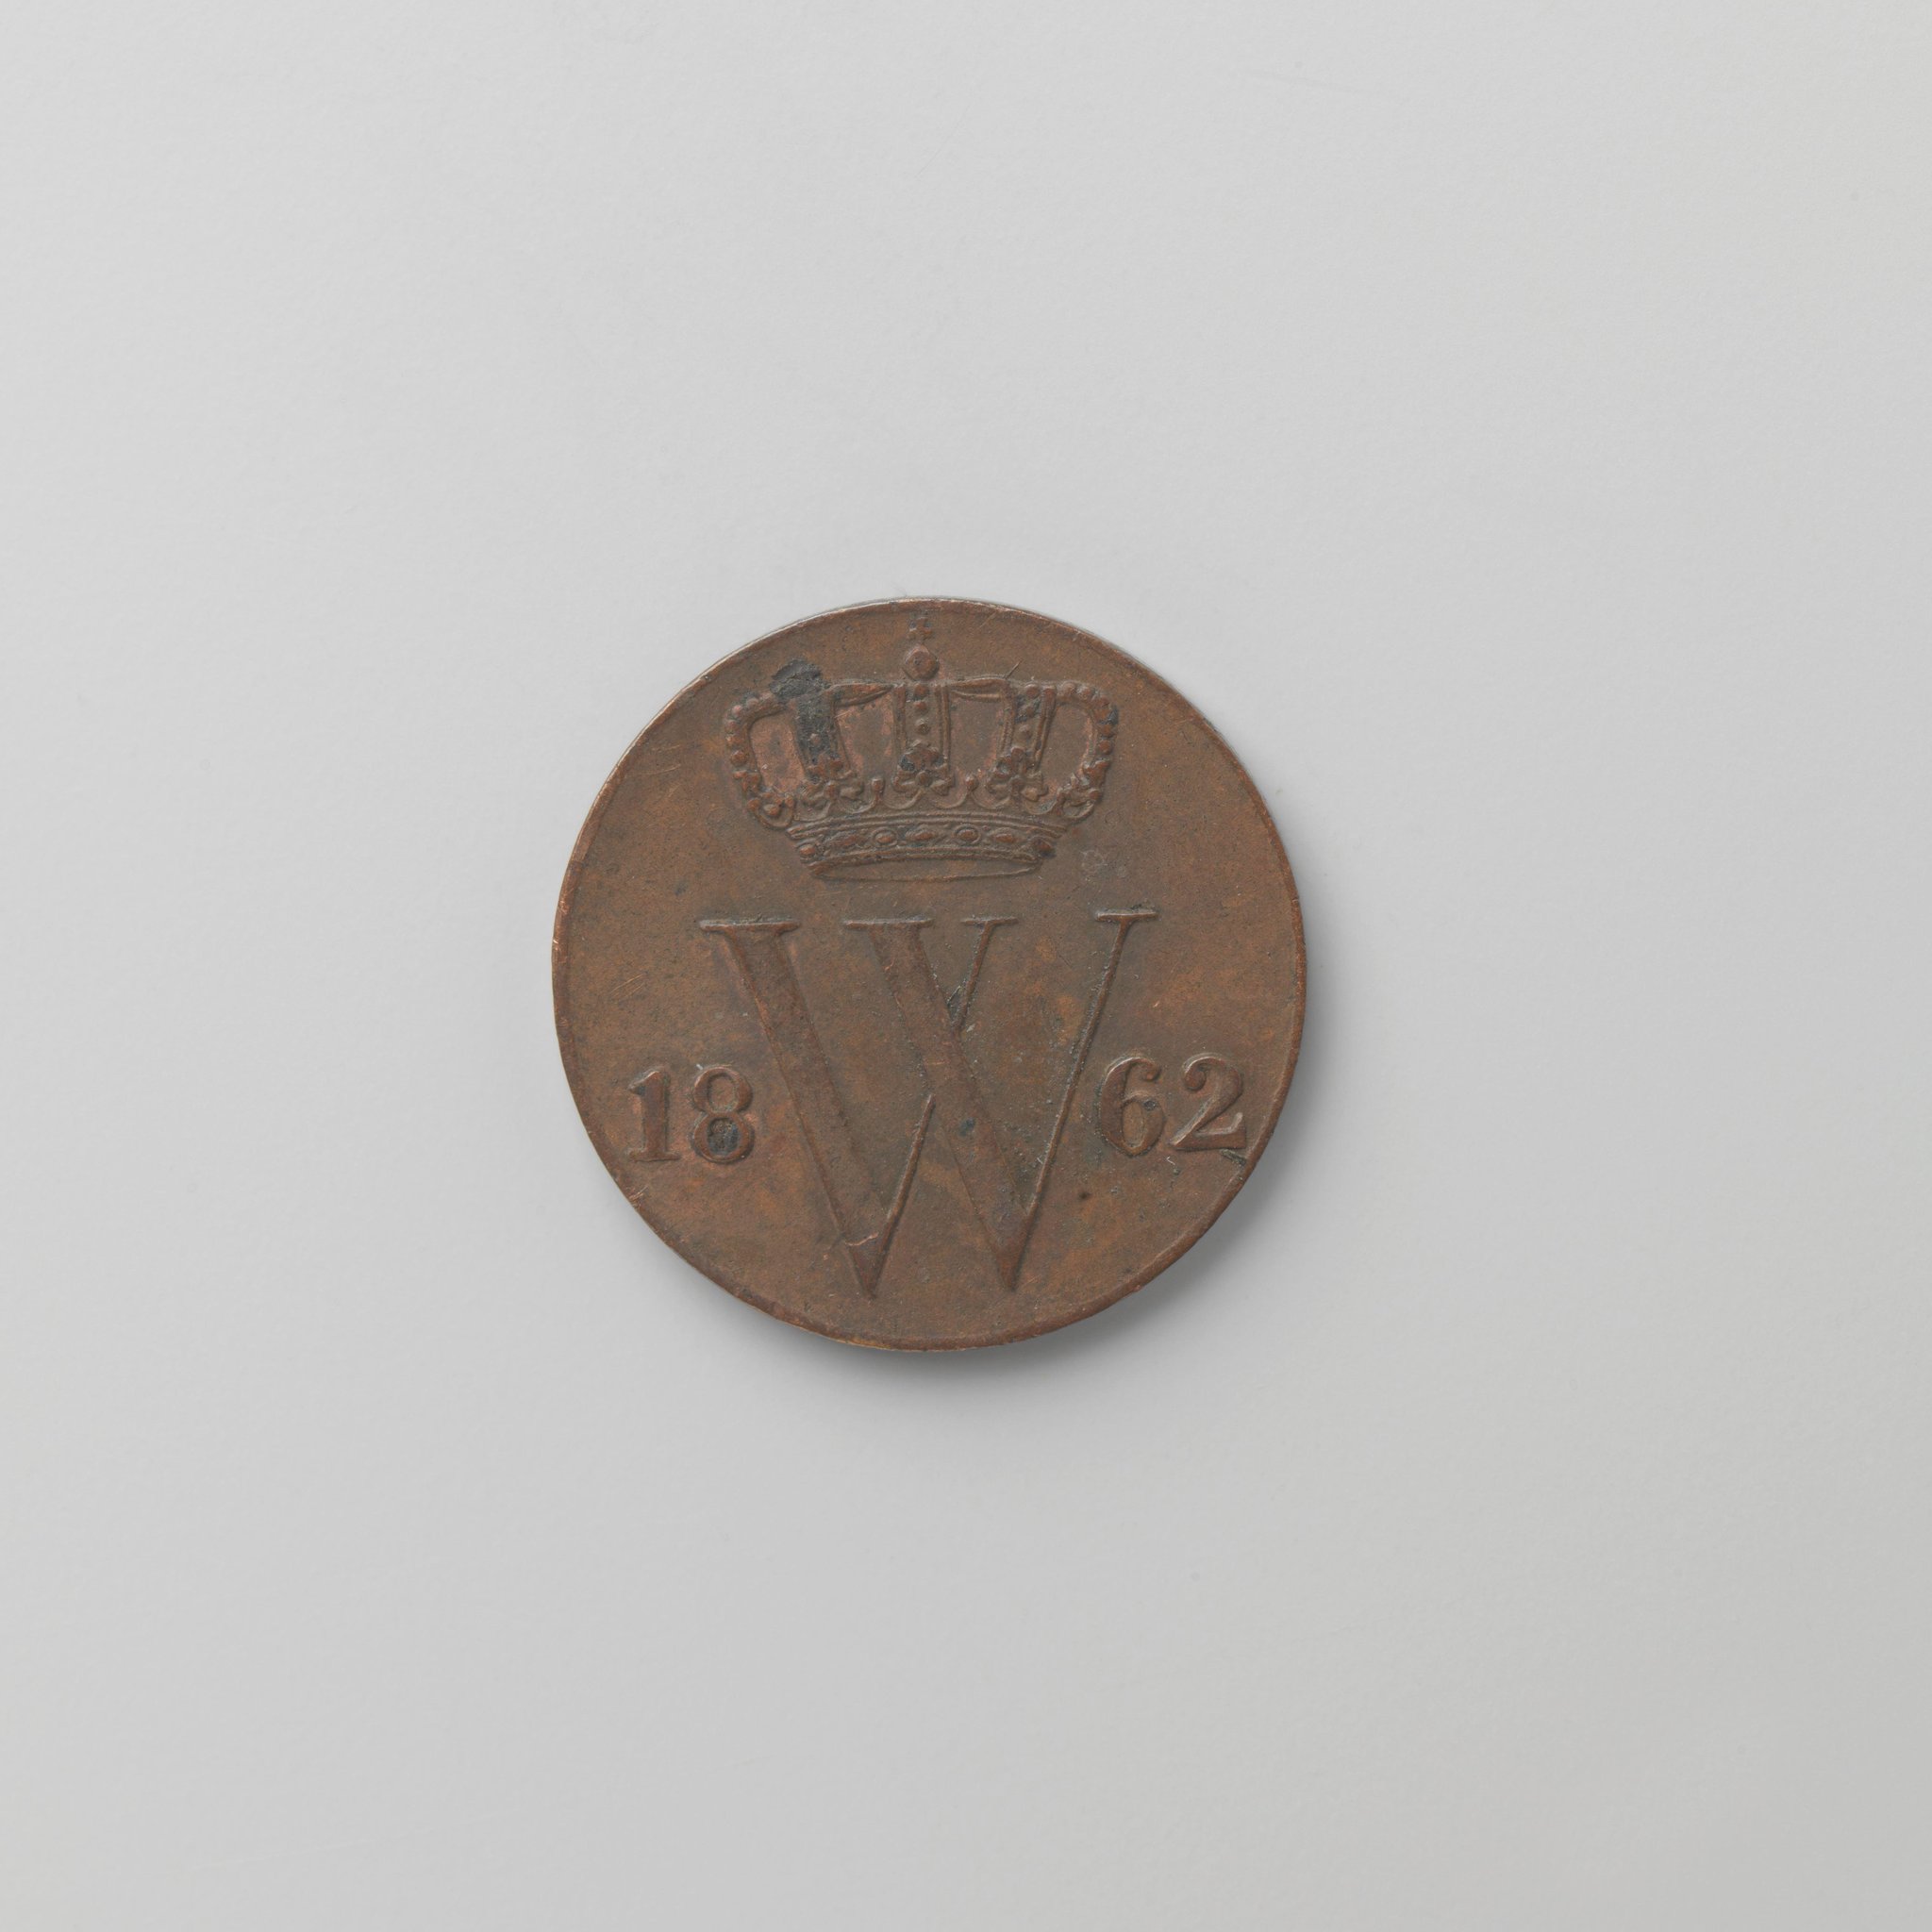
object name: coin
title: Nederlandse ½ cent, 1862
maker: willem iii (koning der nederlanden)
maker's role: koning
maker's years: 1817-1890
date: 1862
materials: copper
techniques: striking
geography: utrecht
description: Koperen munt. Voorzijde: tussen jaartal gekroonde rechte letter W. Keerzijde: tussen waarde-aanduiding ½ C. gekroond rijkswapenschild. Gladde rand.